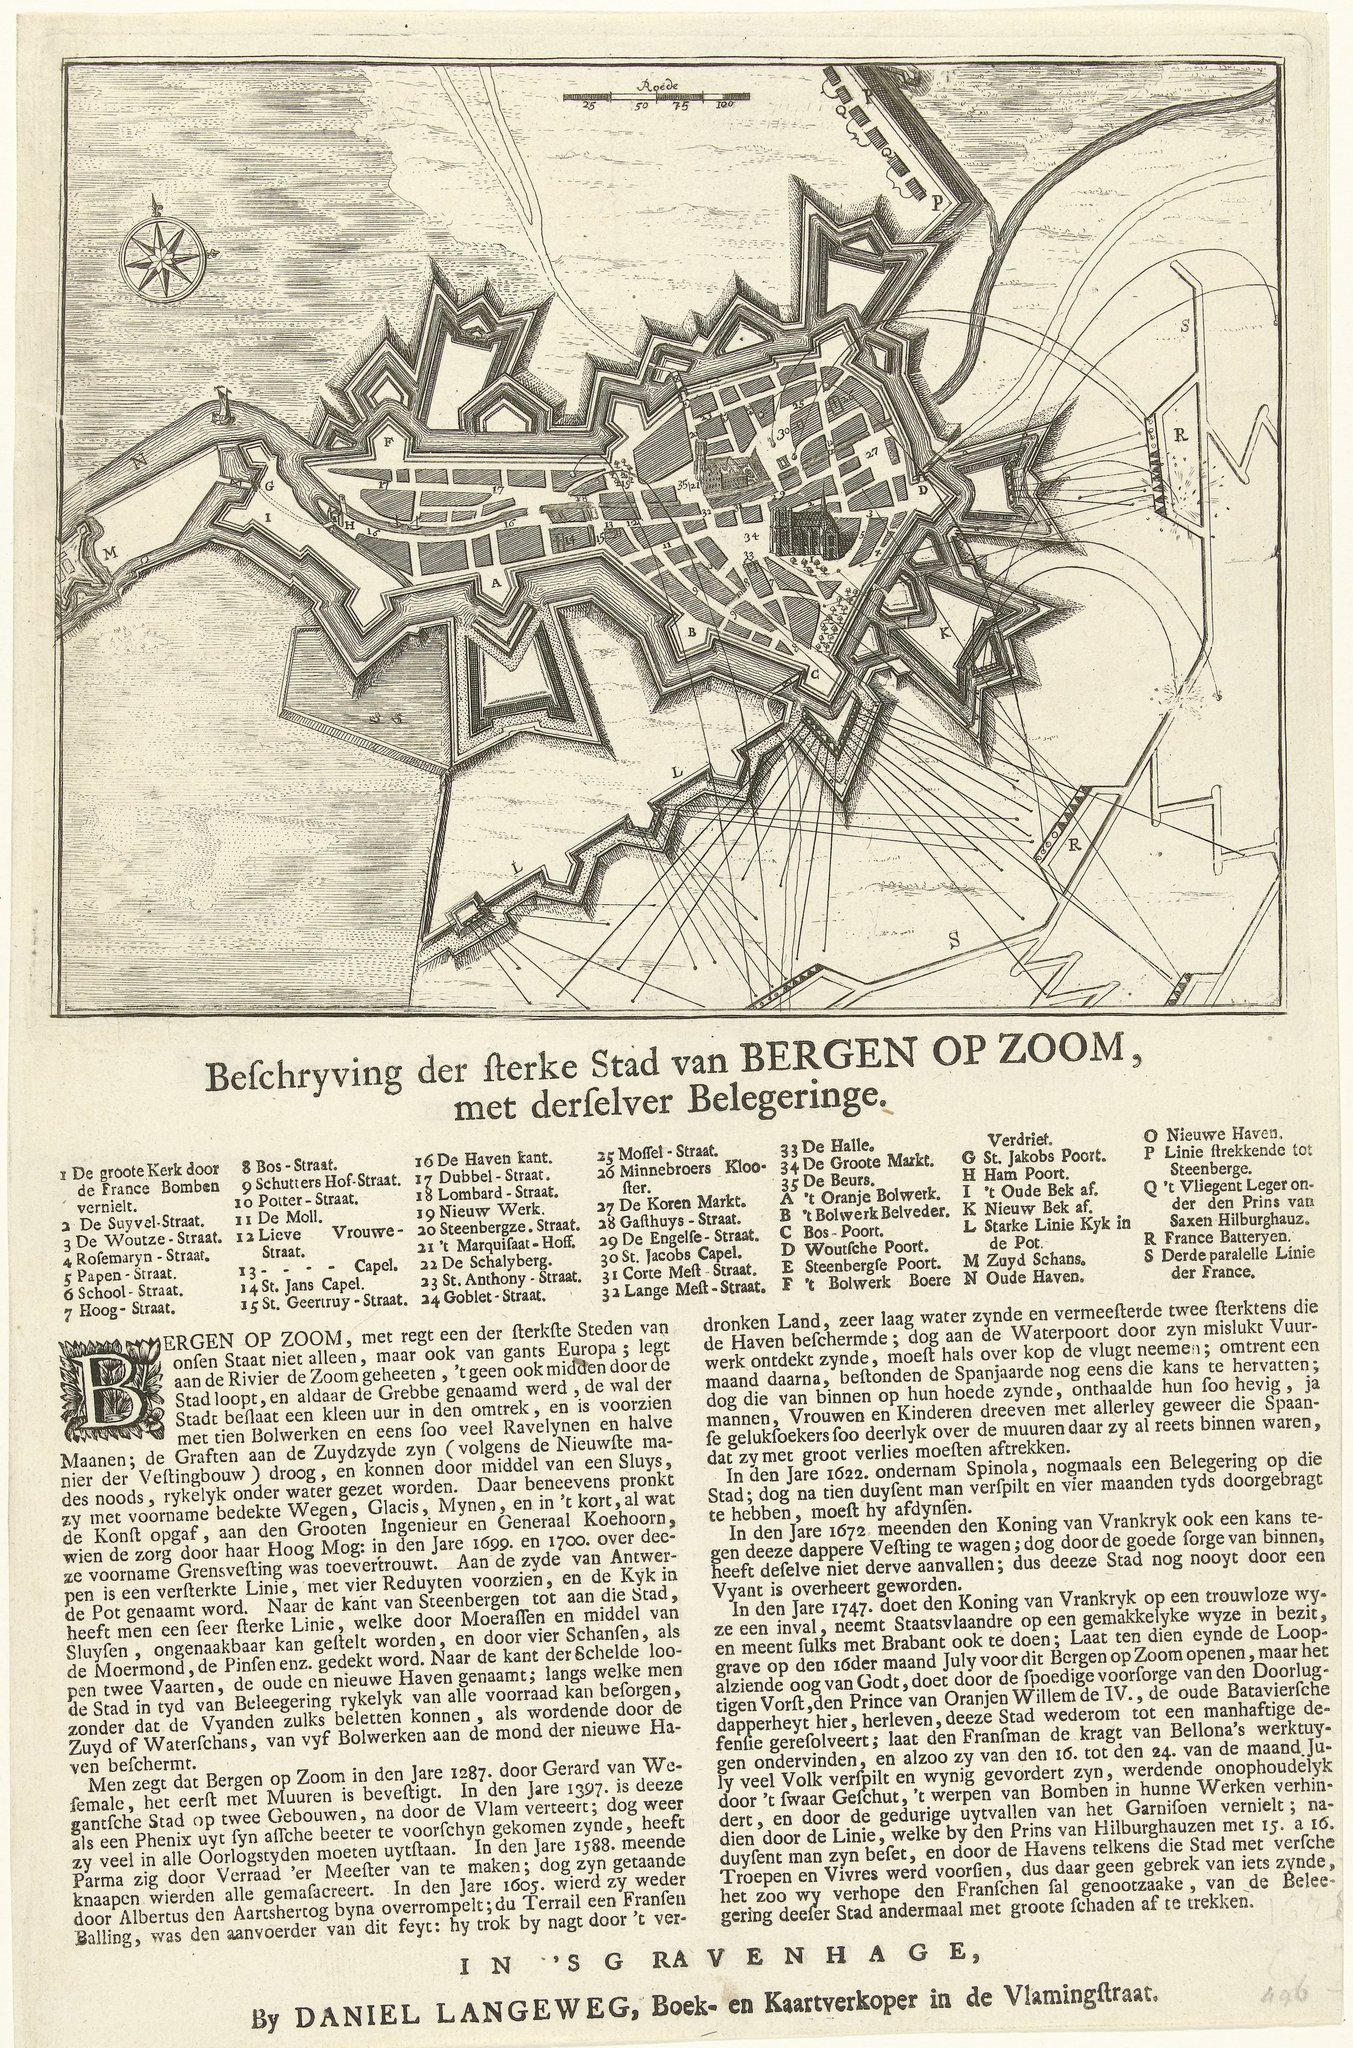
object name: map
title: Plattegrond van het beleg van Bergen op Zoom, 1747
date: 1747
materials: paper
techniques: etching, letterpress printing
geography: northern netherlands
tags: siege, position war, maps of cities, bergen op zoom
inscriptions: collector's mark: ‘G’, collector's mark: Lugt 2228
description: Plattegrond van het beleg van Bergen op Zoom door de Fransen, juli-september 1747. Op het blad onder de plaat een beschrijving van de stad met de legenda 1-35 en A-S in het Nederlands.